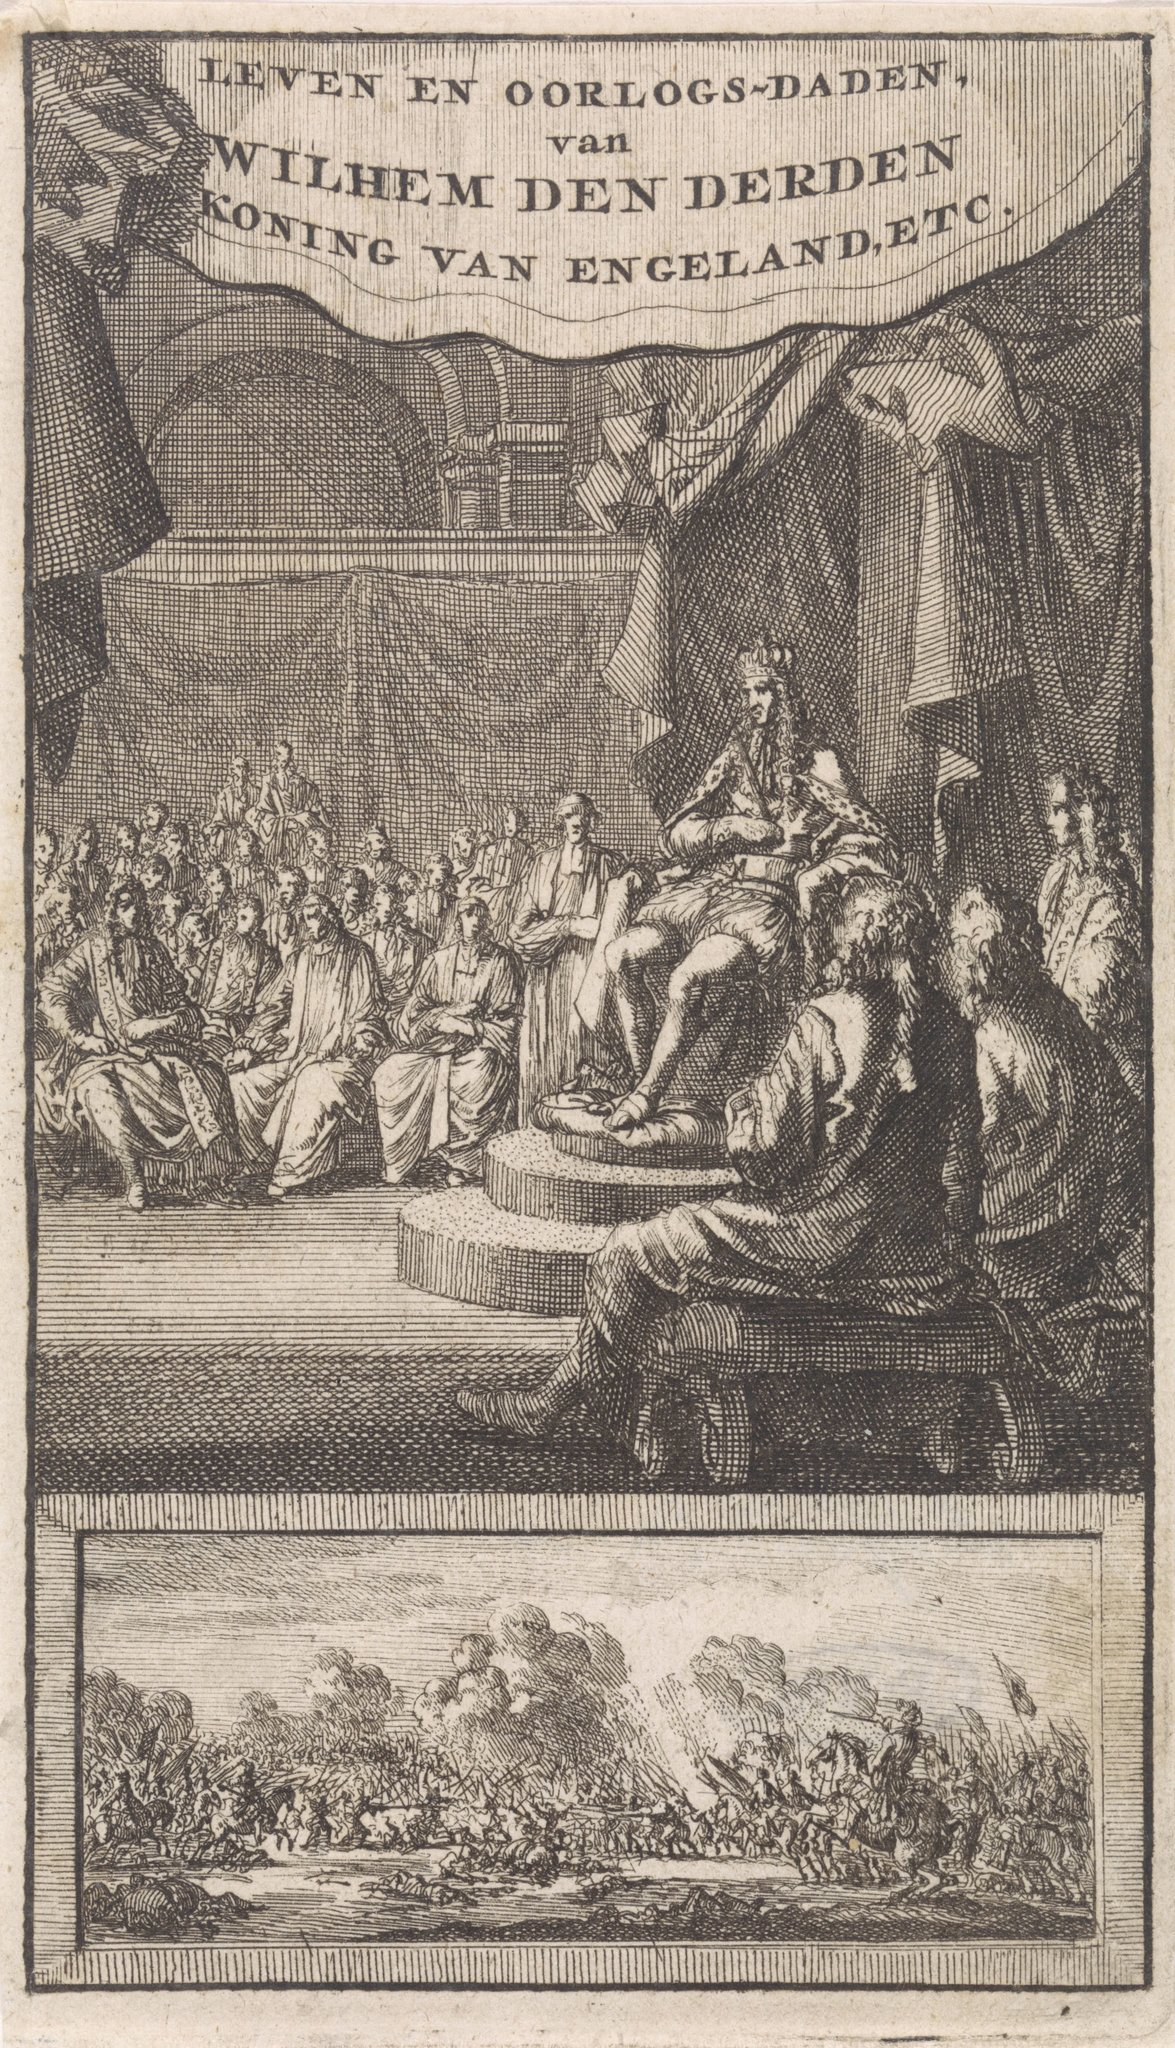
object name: titelblad, titelpagina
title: Titelpagina voor: A. Montanus, Het leven, bedryf, en oorlogs-daaden van Wilhem den Derden 1703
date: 1703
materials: paper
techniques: etching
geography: amsterdam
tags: william iii (prince of orange and king of england, scotland, and ireland), throne, lower house, parliament, chamber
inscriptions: collector's mark: Lugt 2228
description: Titelpagina voor: Montanus, Arnoldus. Het leven, bedryf, en oorlogs-daaden van Wilhem den Derden, 4 delen. Amsterdam: Jan Claesz ten Hoorn, 1703.